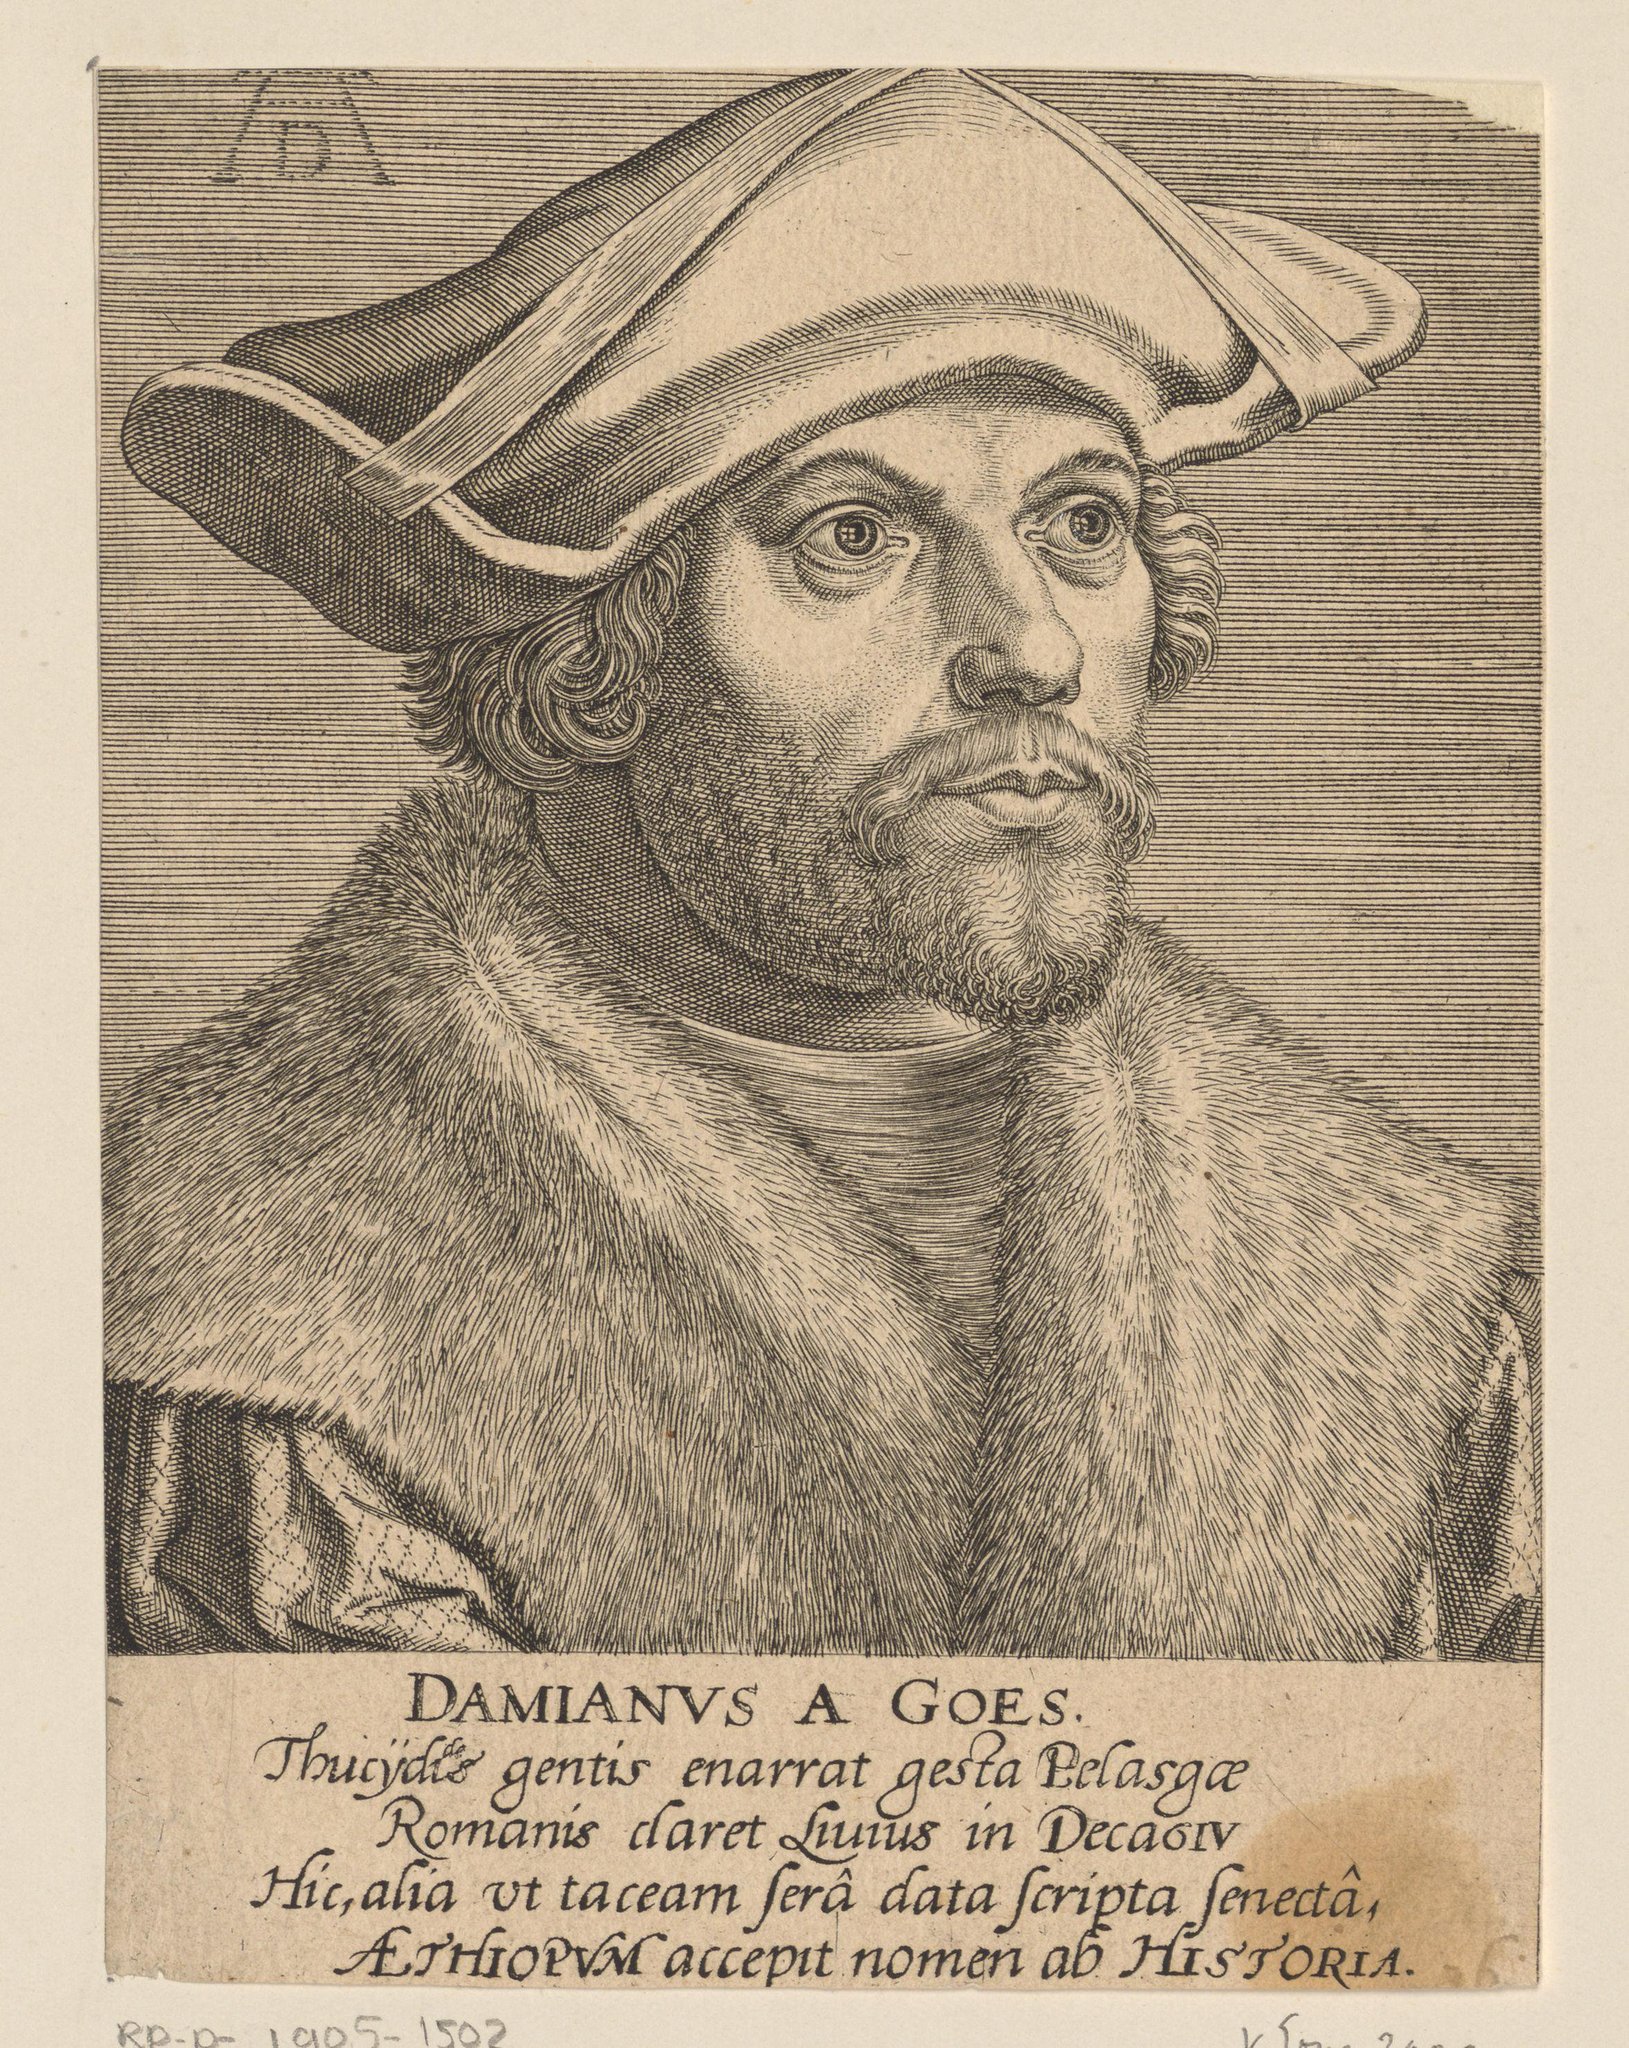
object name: print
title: Portret van Damiao de Gois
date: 1549-1612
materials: paper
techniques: engraving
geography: antwerp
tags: historical persons, historical disciplines; philology (+ portrait of scholar, scientist)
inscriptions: collector's mark: Lugt 2228